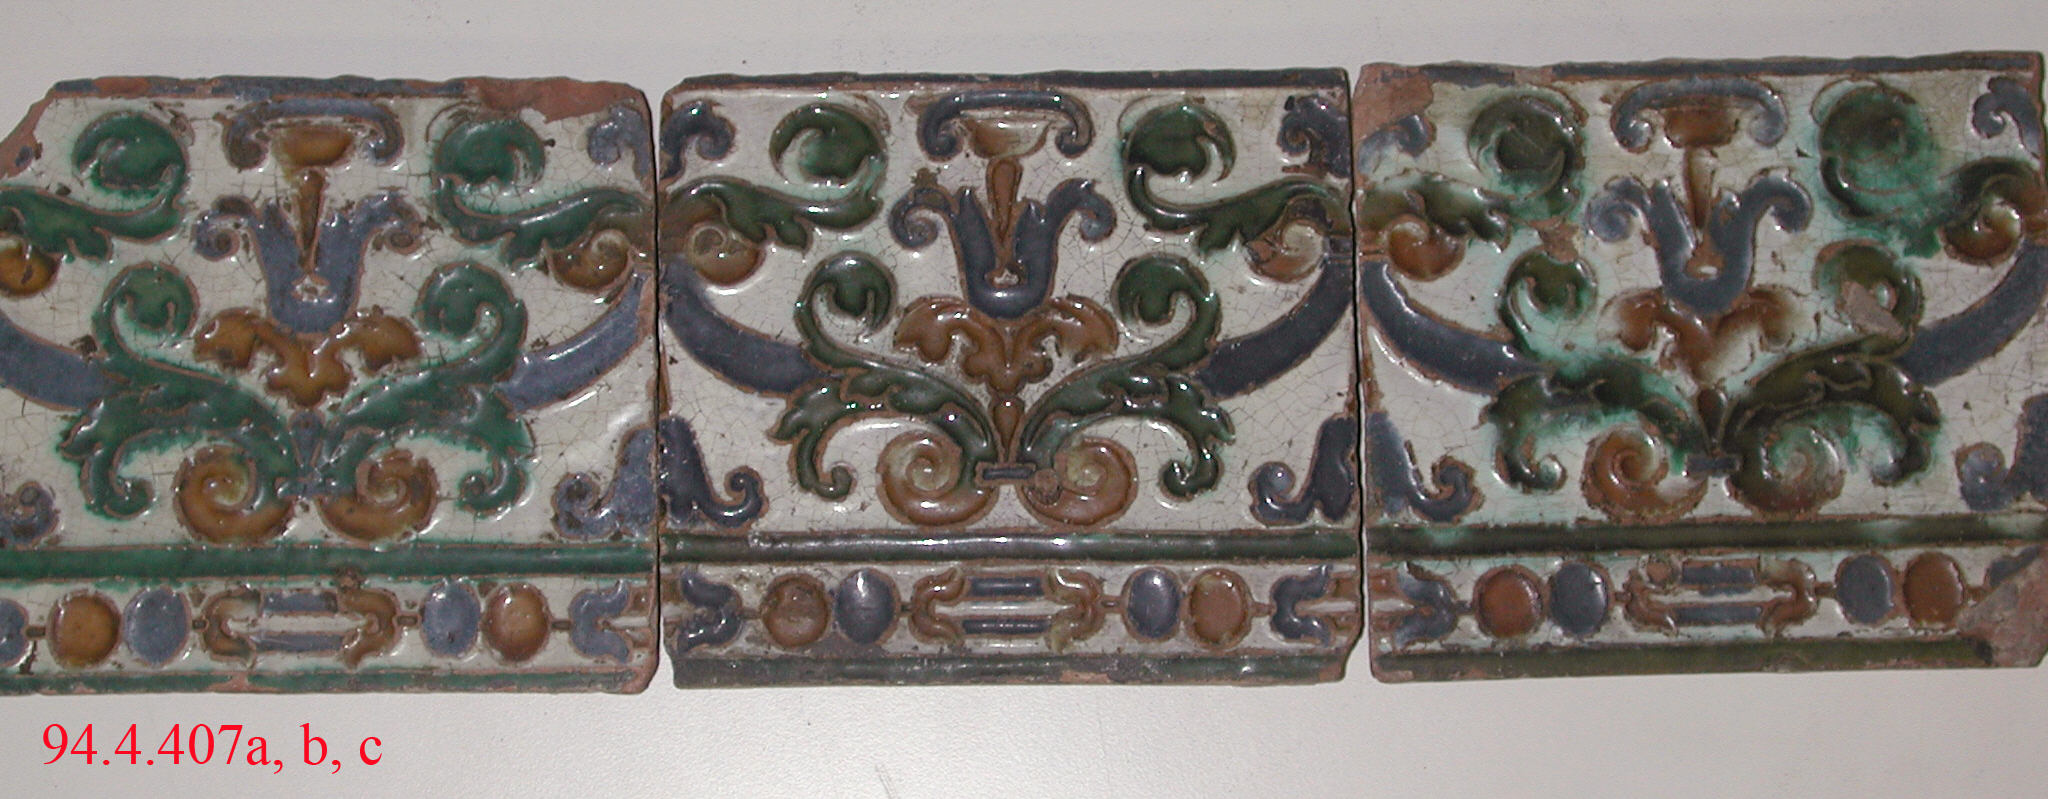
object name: wall tile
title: Walls tiles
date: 1501-1600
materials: earthenware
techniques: glazing